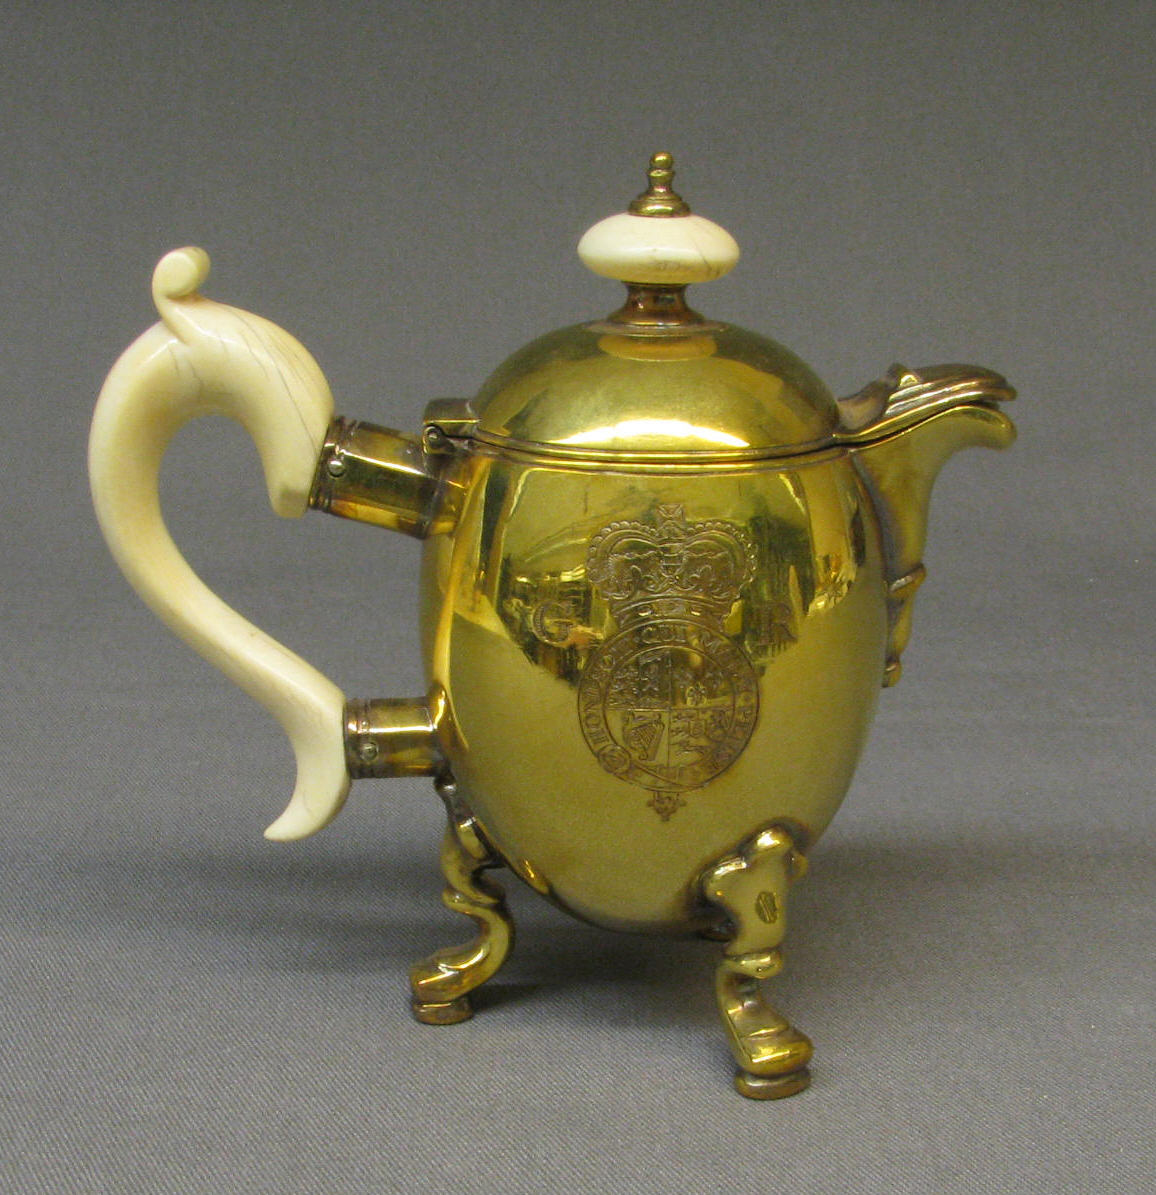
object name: jug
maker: simon pantin i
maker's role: maker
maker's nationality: british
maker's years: 1672-1728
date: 1727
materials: ivory, silver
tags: coat of arms